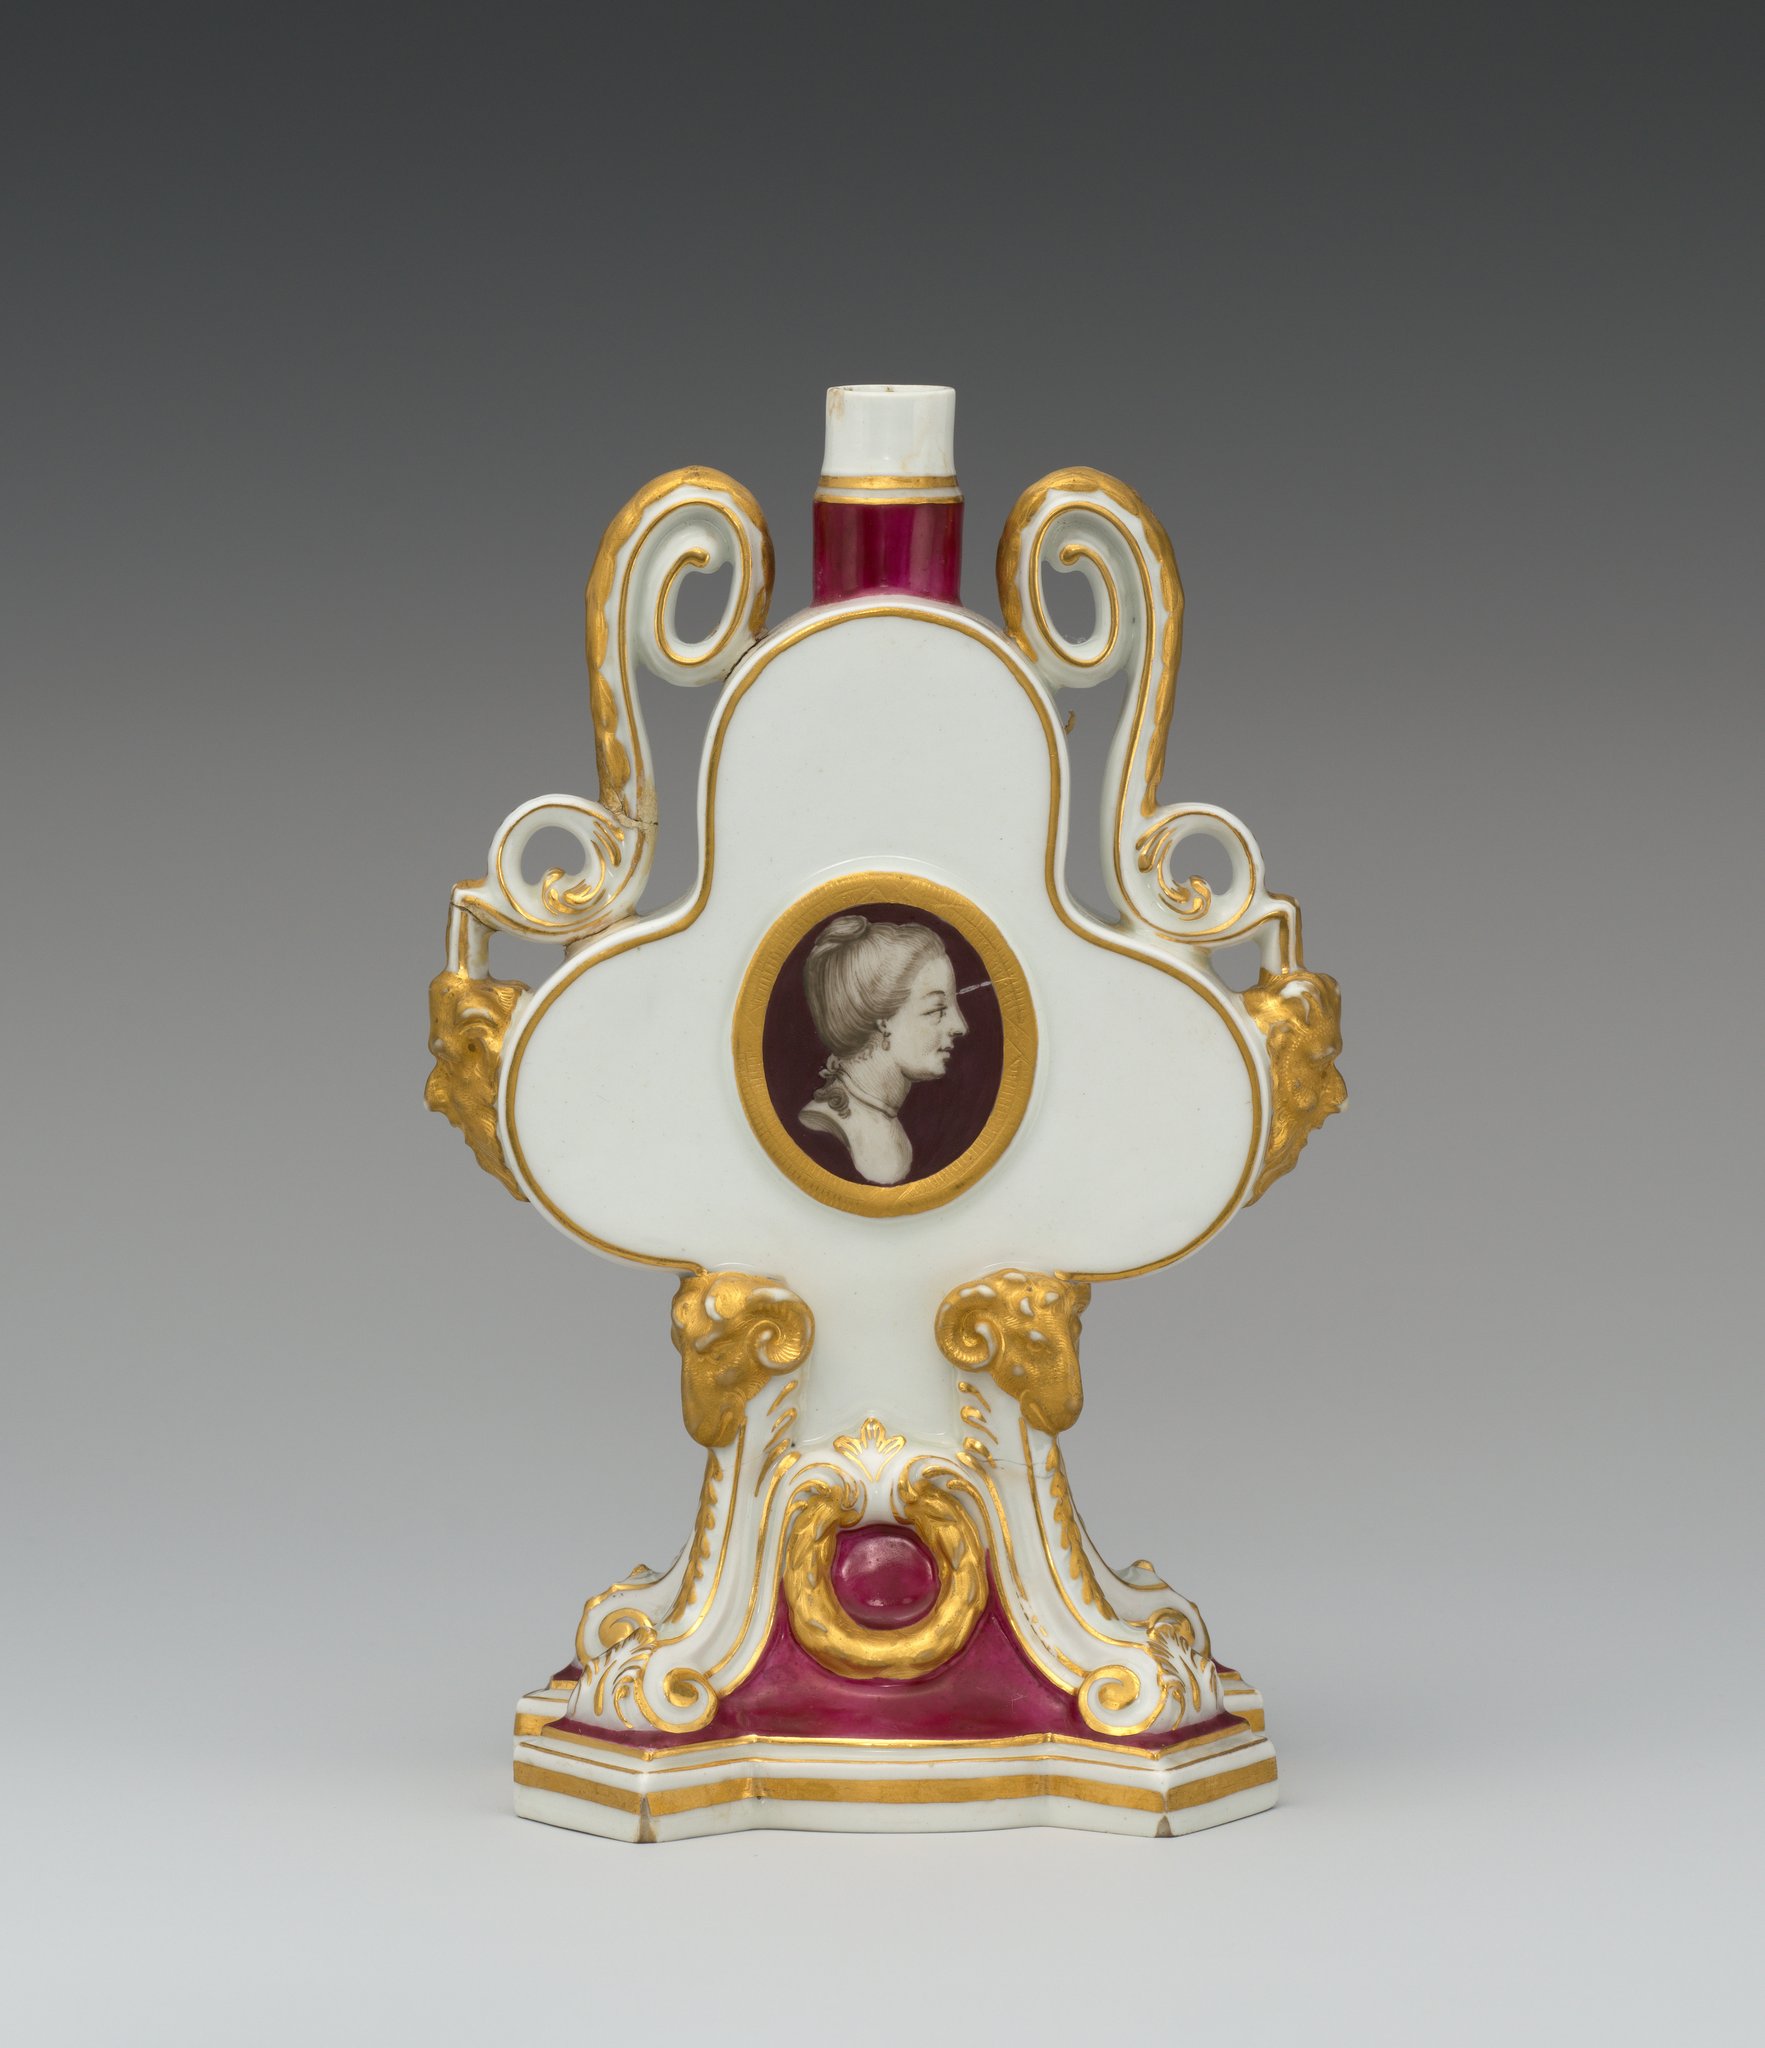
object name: toilet bottle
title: Toilet bottle (one of a pair)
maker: chelsea porcelain manufactory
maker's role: factory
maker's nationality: british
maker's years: 1744-1784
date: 1760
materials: soft paste porcelain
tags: women